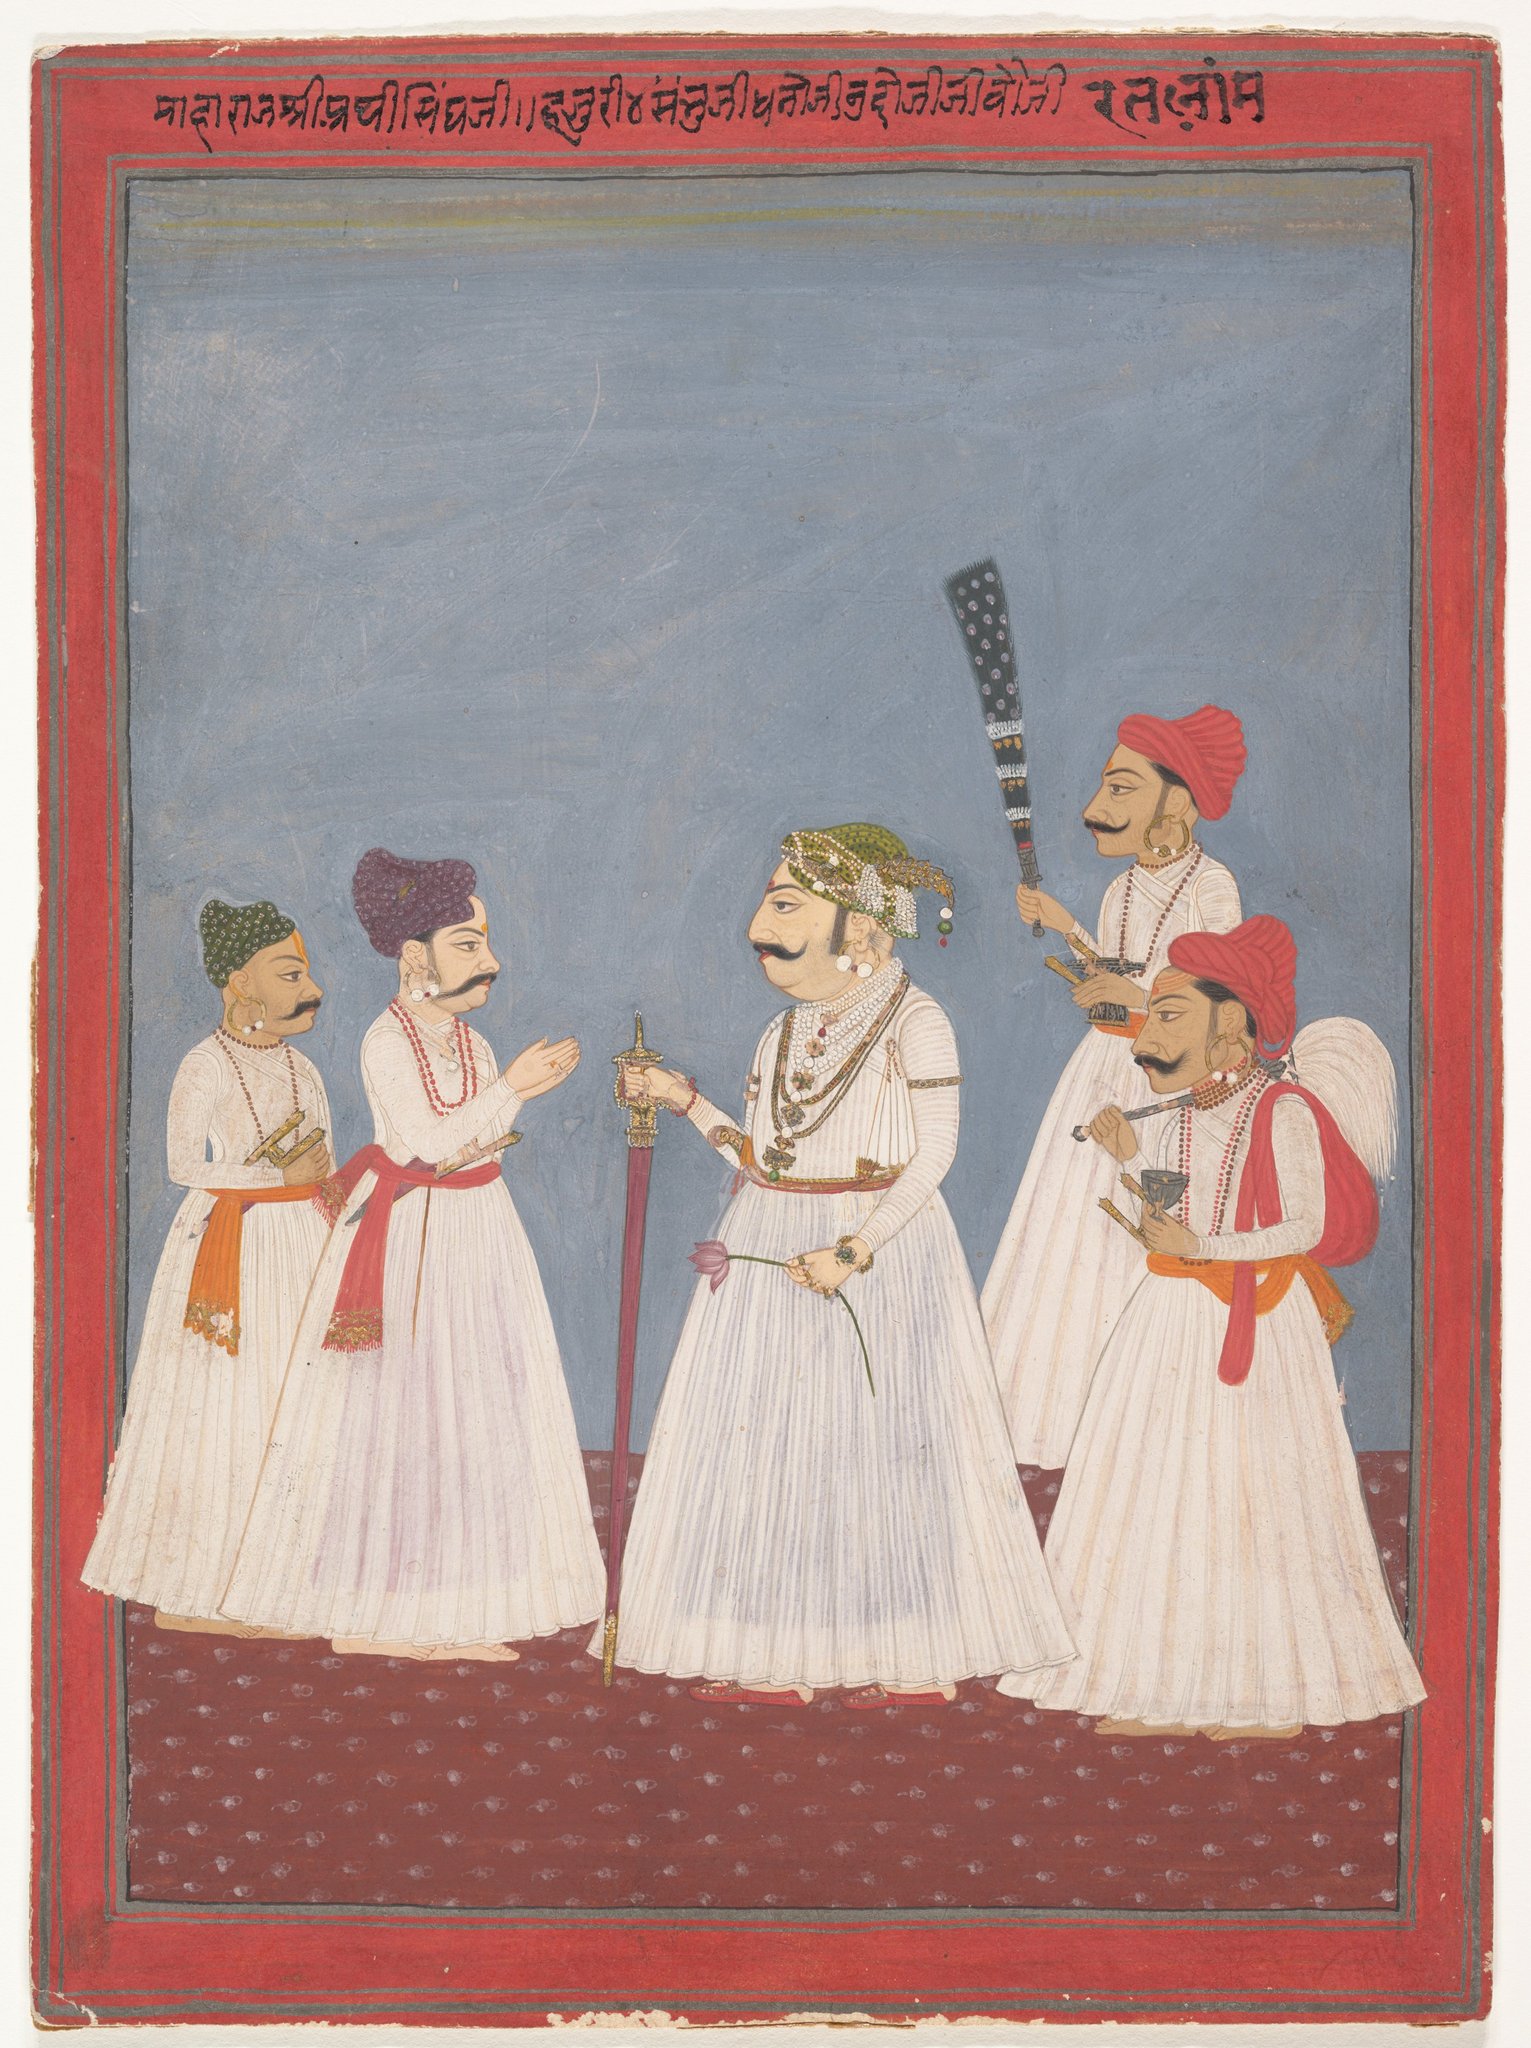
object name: painting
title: Prince with Four Attendants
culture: indian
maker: sri prathi singh of ratlam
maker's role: artist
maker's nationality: indian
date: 1767-1833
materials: ink, paper, watercolor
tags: swords,princes,men